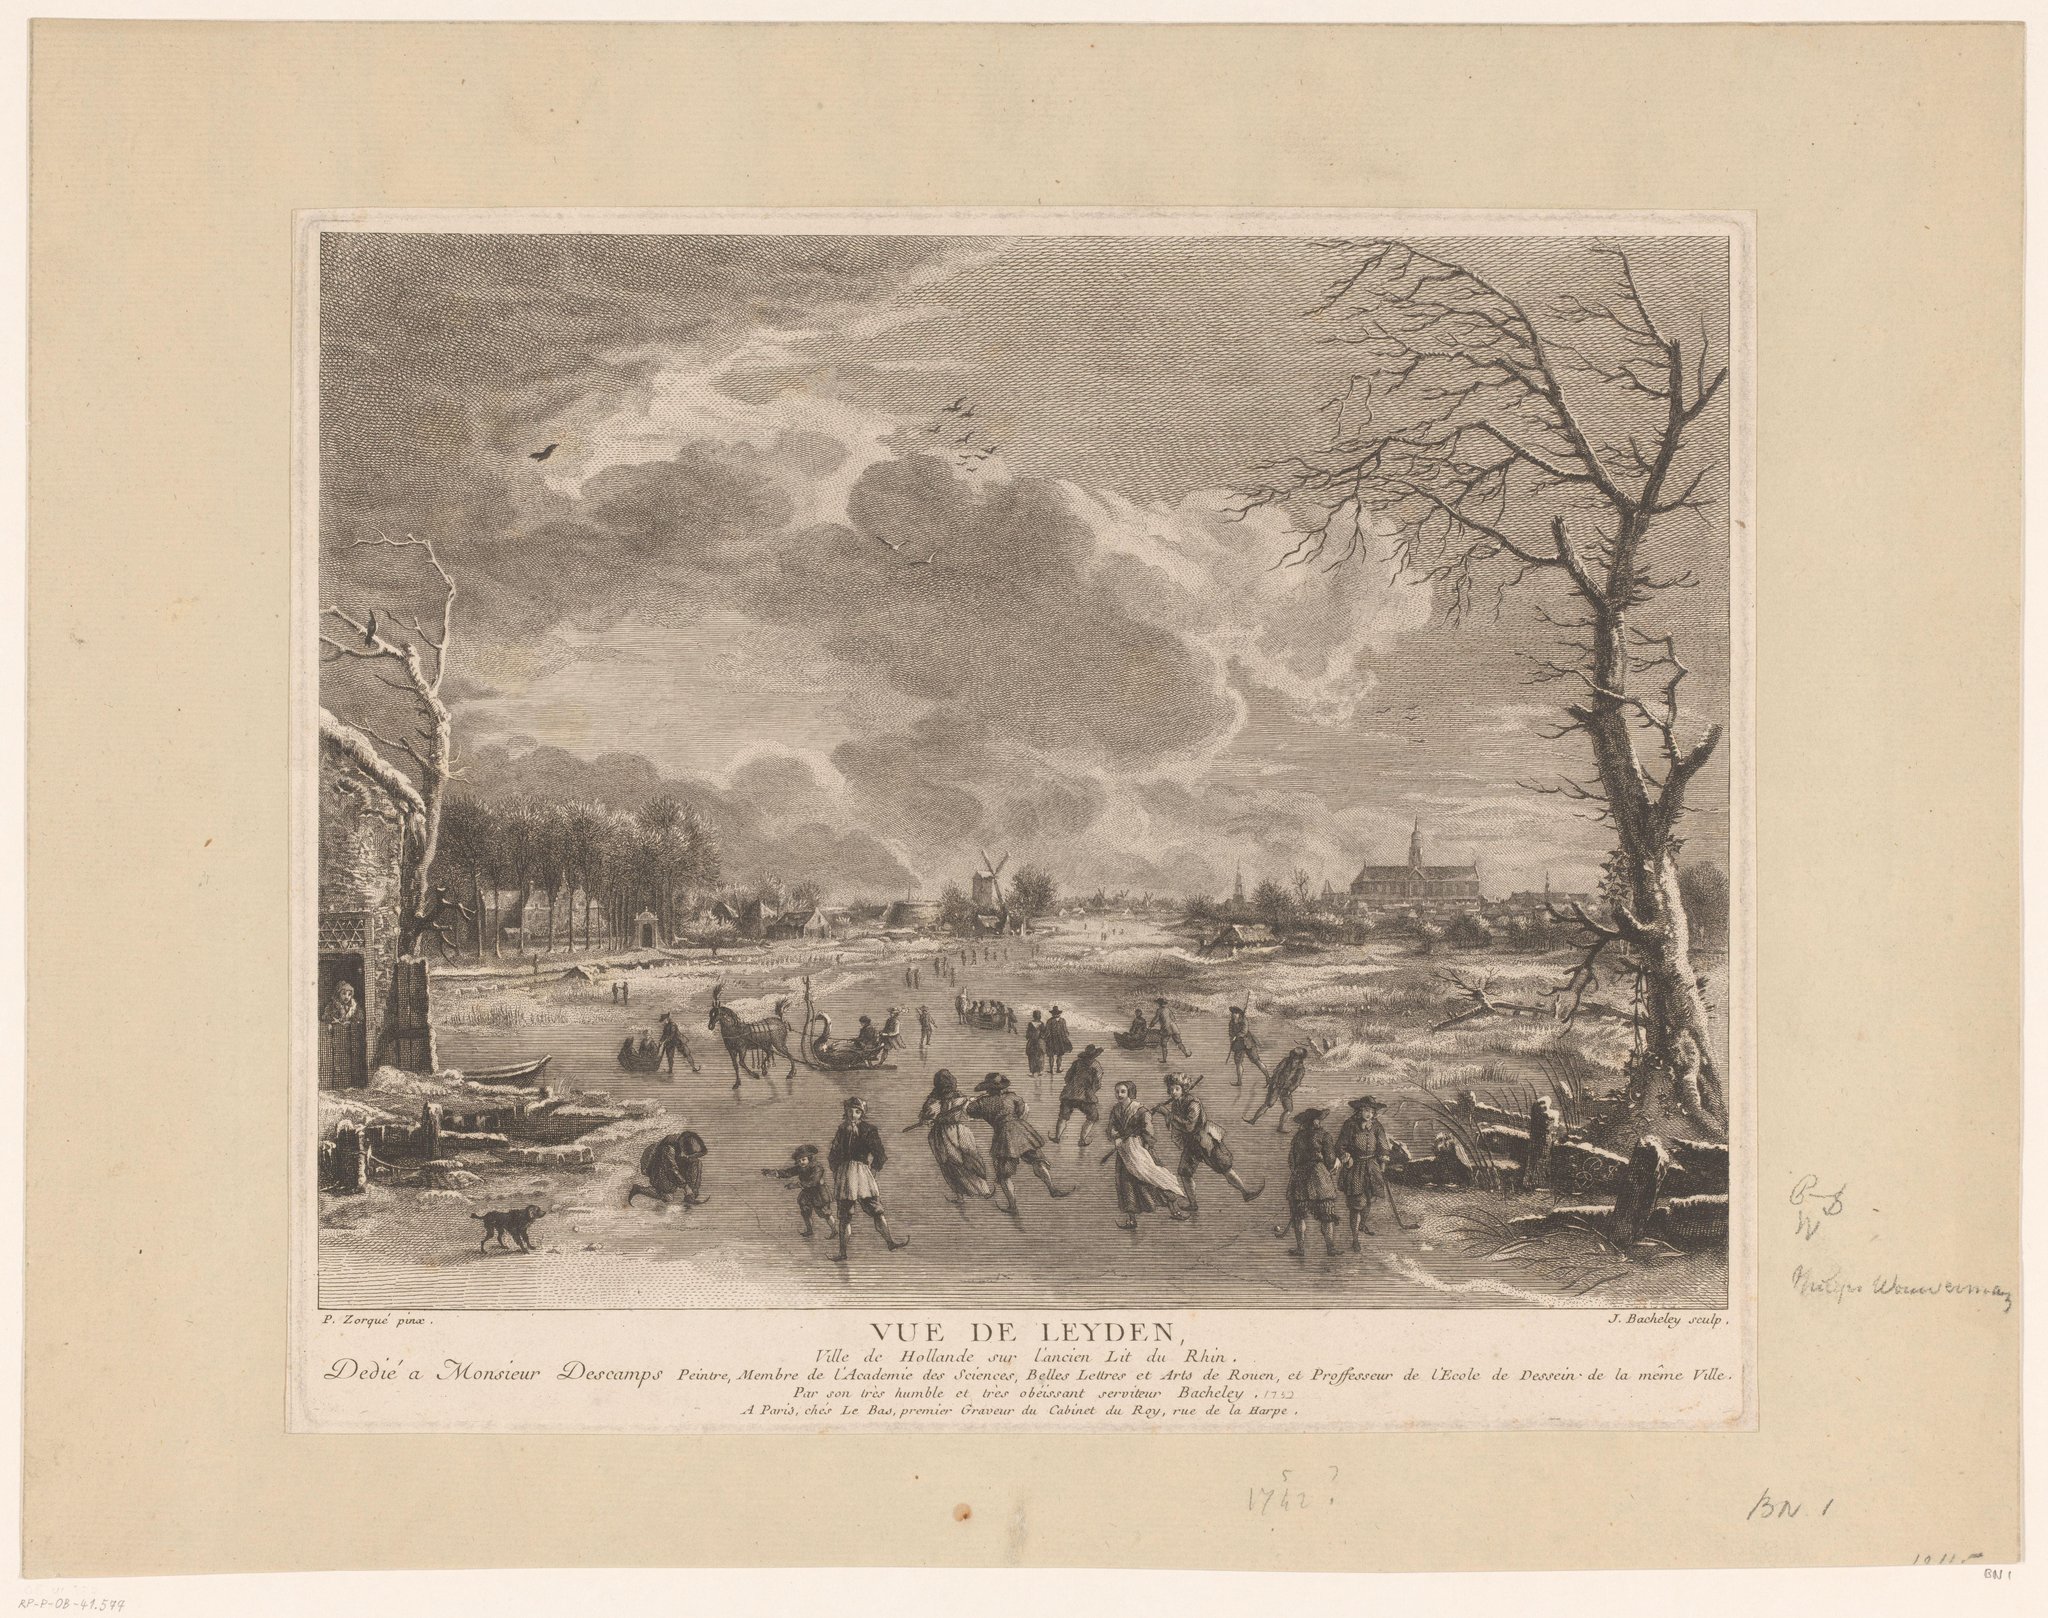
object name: print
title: Wintergezicht op Leiden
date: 1730-1781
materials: paper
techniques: engraving, etching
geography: rouen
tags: church (exterior), ice ~ freezing weather, skates (winter sports), sledge, sleigh (winter sports), prospect of city, town panorama, silhouette of city, leiden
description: Op het ijs schaatsers en sleeën. Op de achtergrond Leiden, met rechts de Hooglandse kerk.